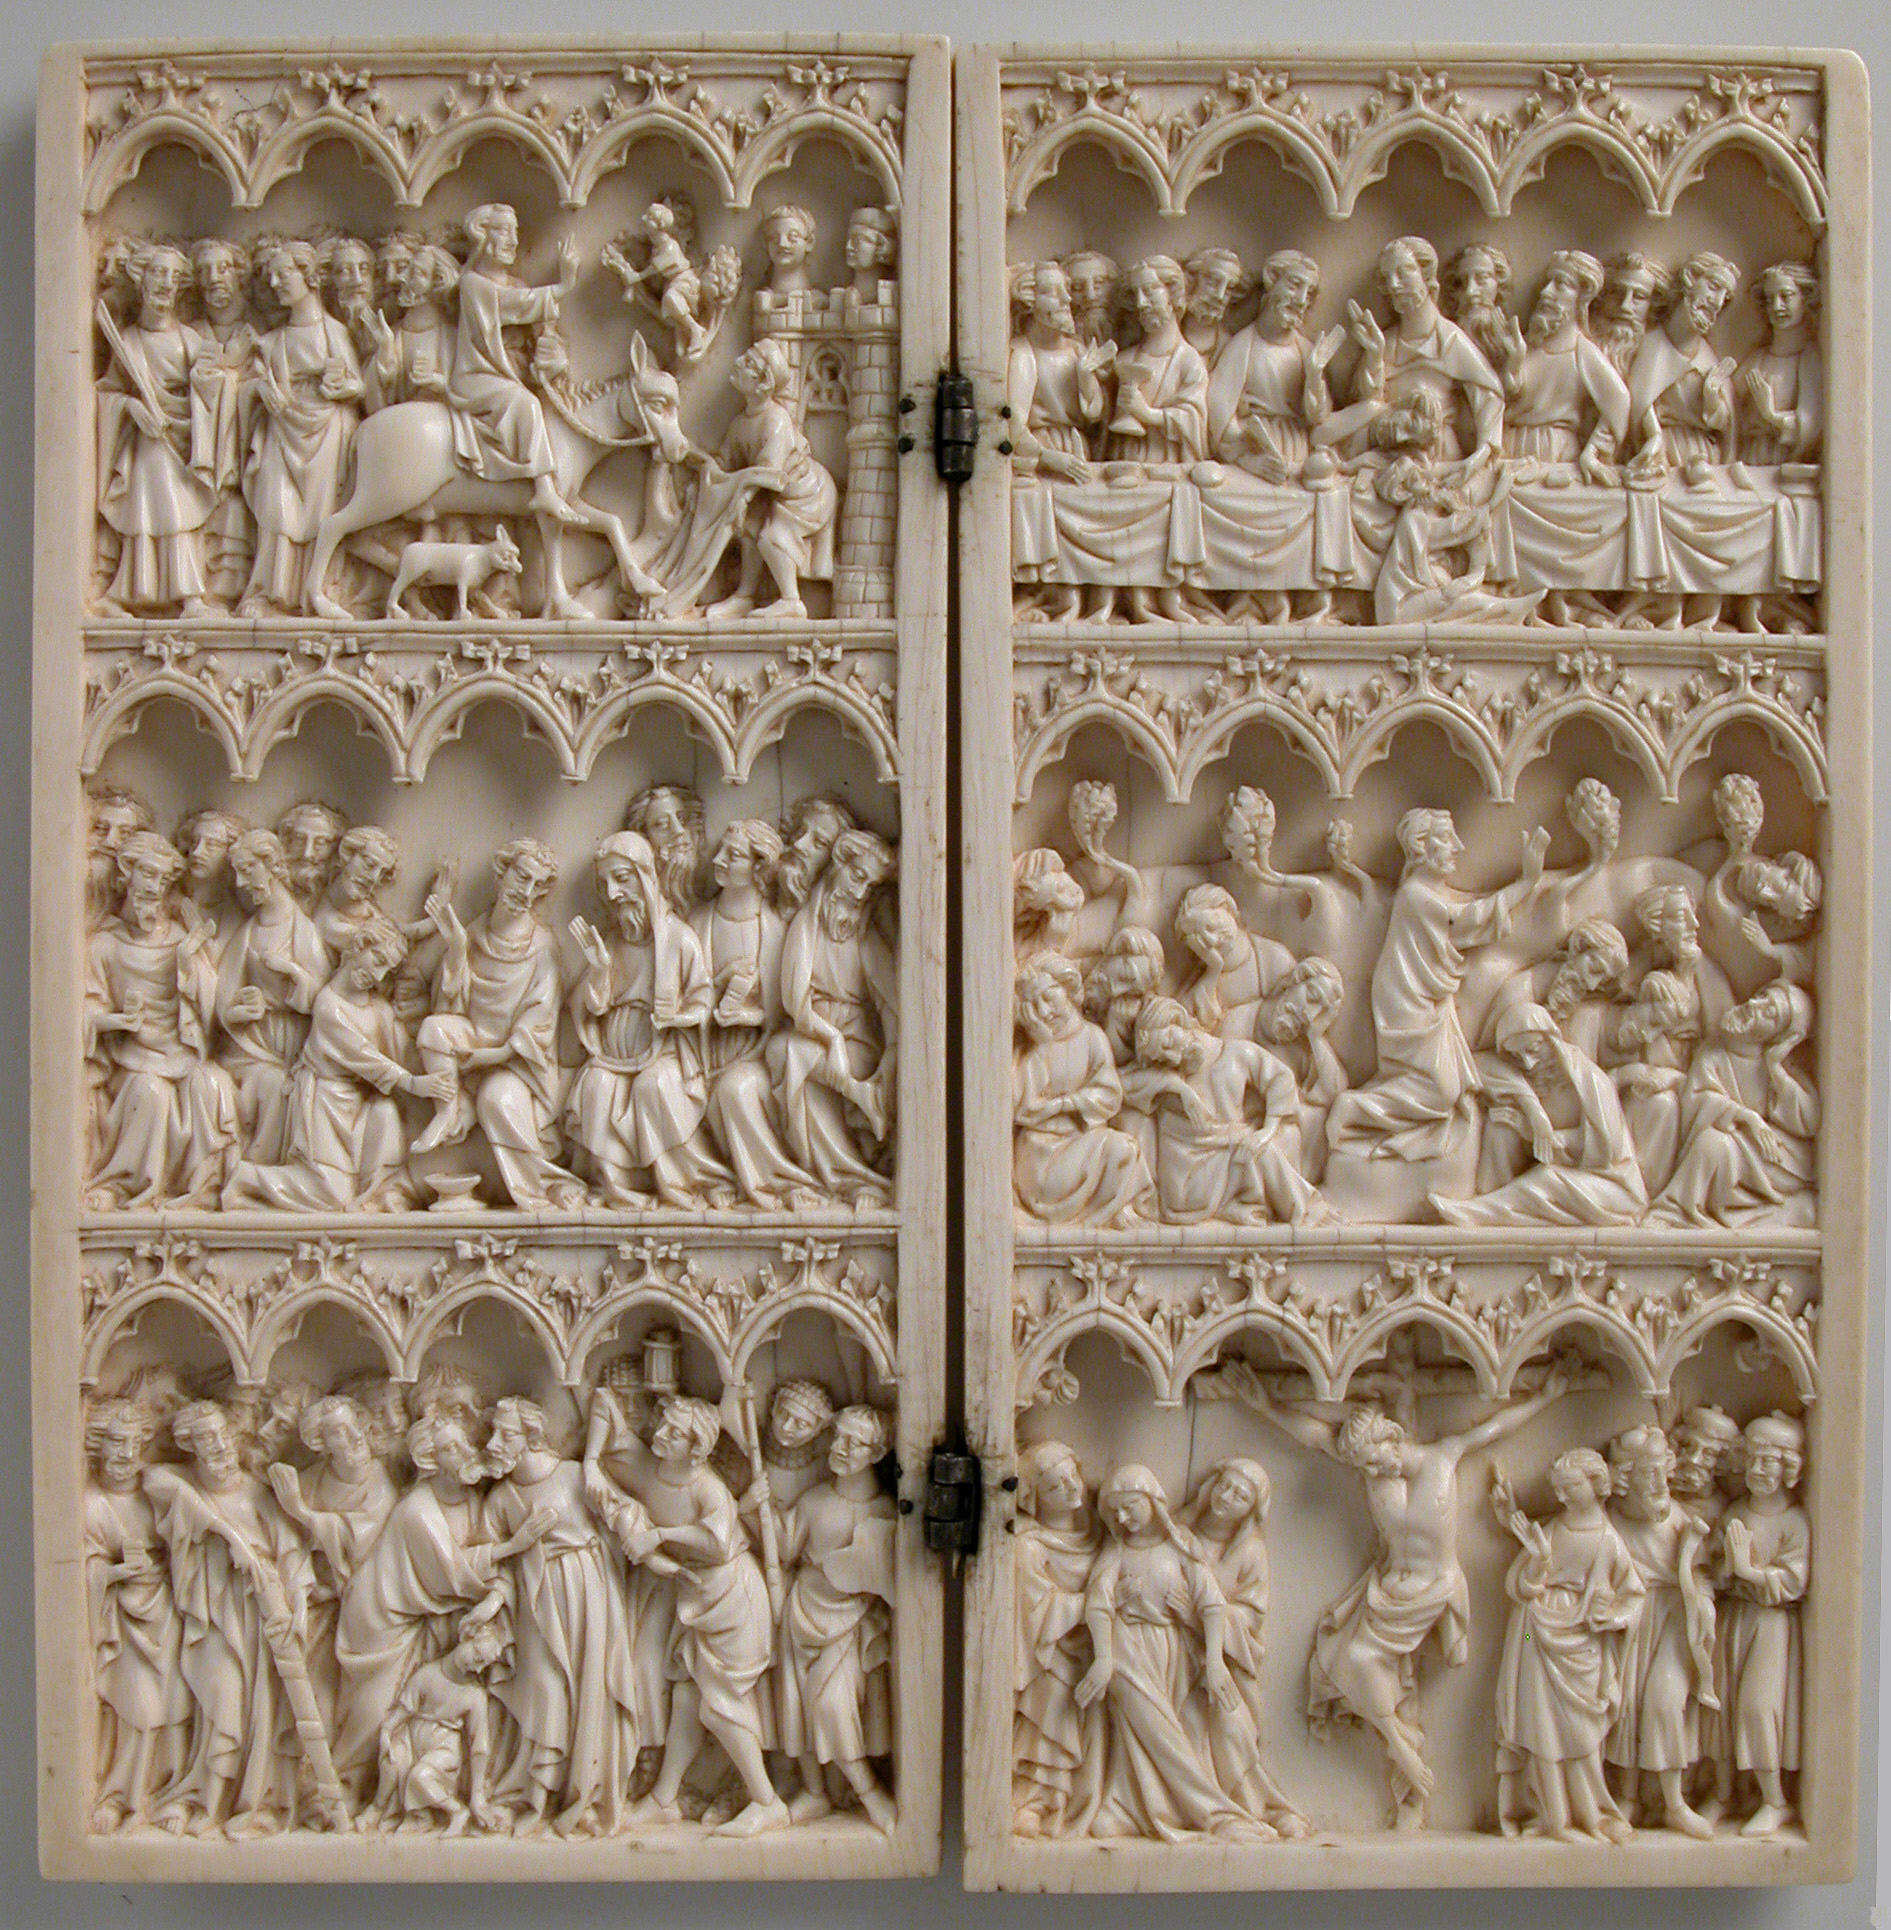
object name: diptych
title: Diptych with Scenes from the Passion of Jesus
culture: french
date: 1350-1375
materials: ivory, metal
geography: france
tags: animals,men,women,christ,judas,crucifixion,last supper,agony in the garden